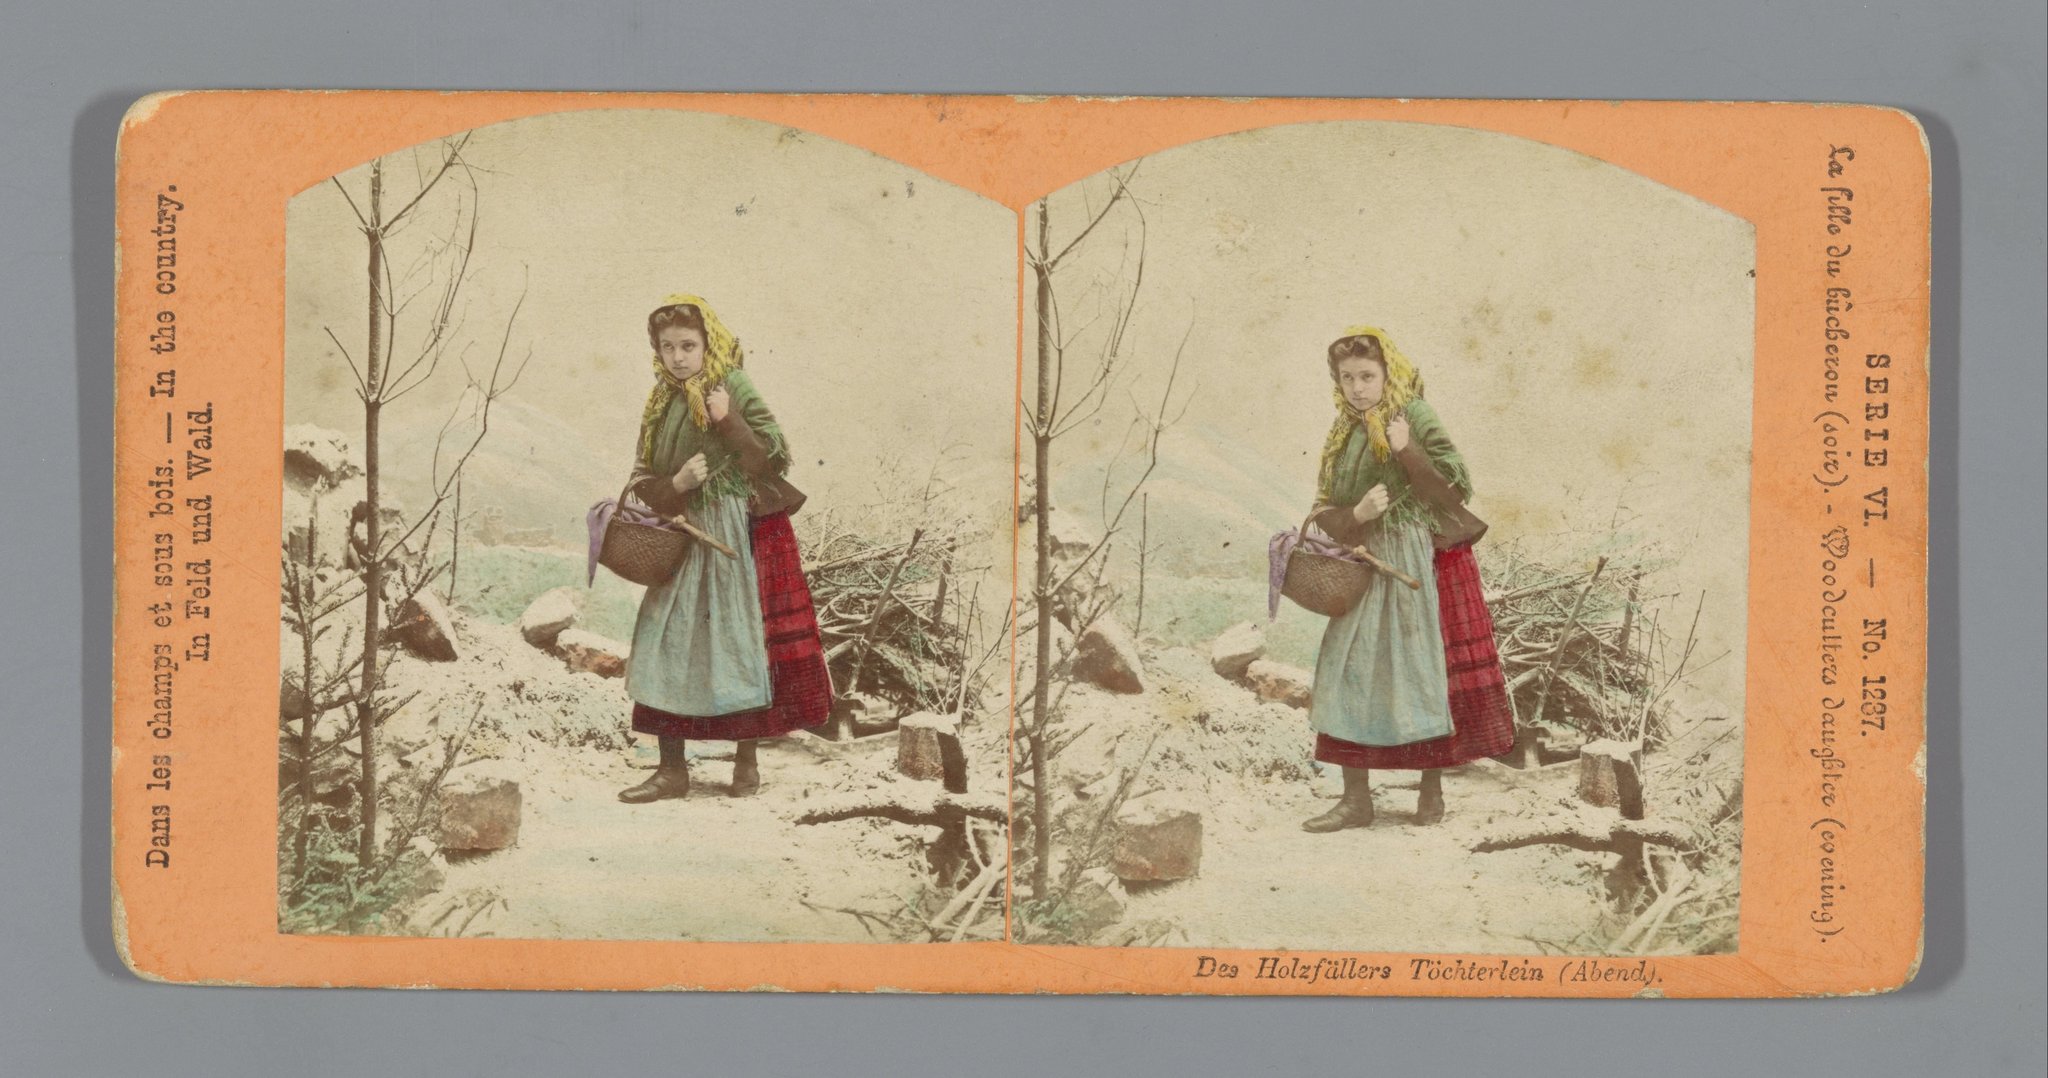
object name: stereograph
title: La fille du bûcheron (soir) / Woodcutters daughter (evening) / Des Holzfällers Töchterlein (Abend)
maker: Anonymous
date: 1868-1890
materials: cardboard, paper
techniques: albumen print, hand coloring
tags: adolescent, young woman, maiden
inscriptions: inscription: ‘SERIE VI. - No. 1237.’